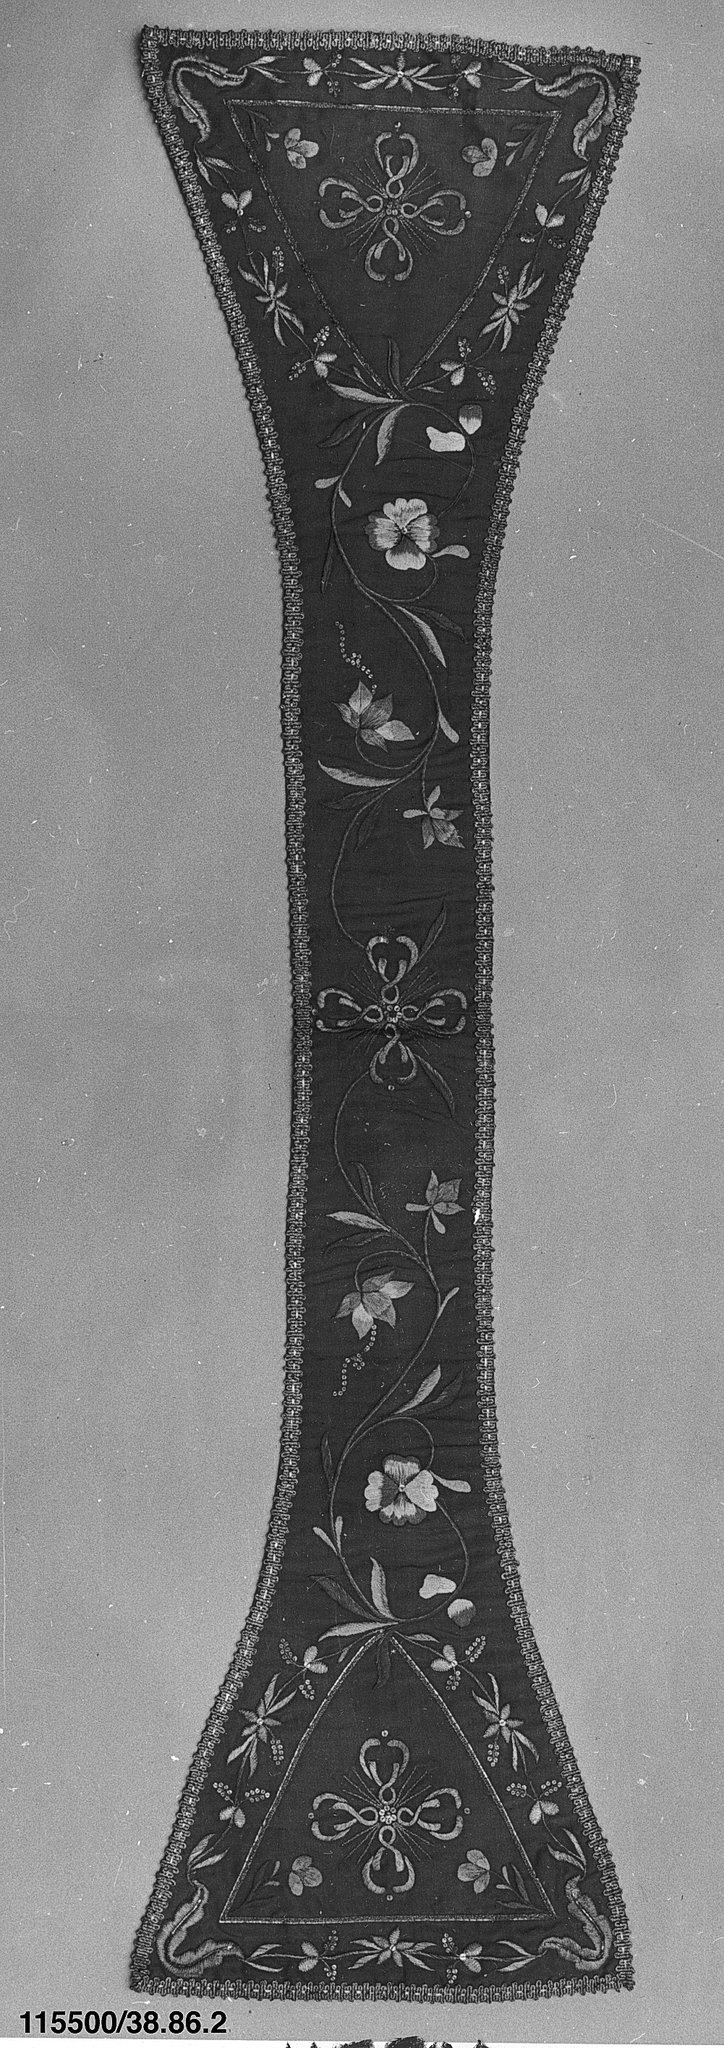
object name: maniple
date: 1890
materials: metal thread, silk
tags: flowers,leaves